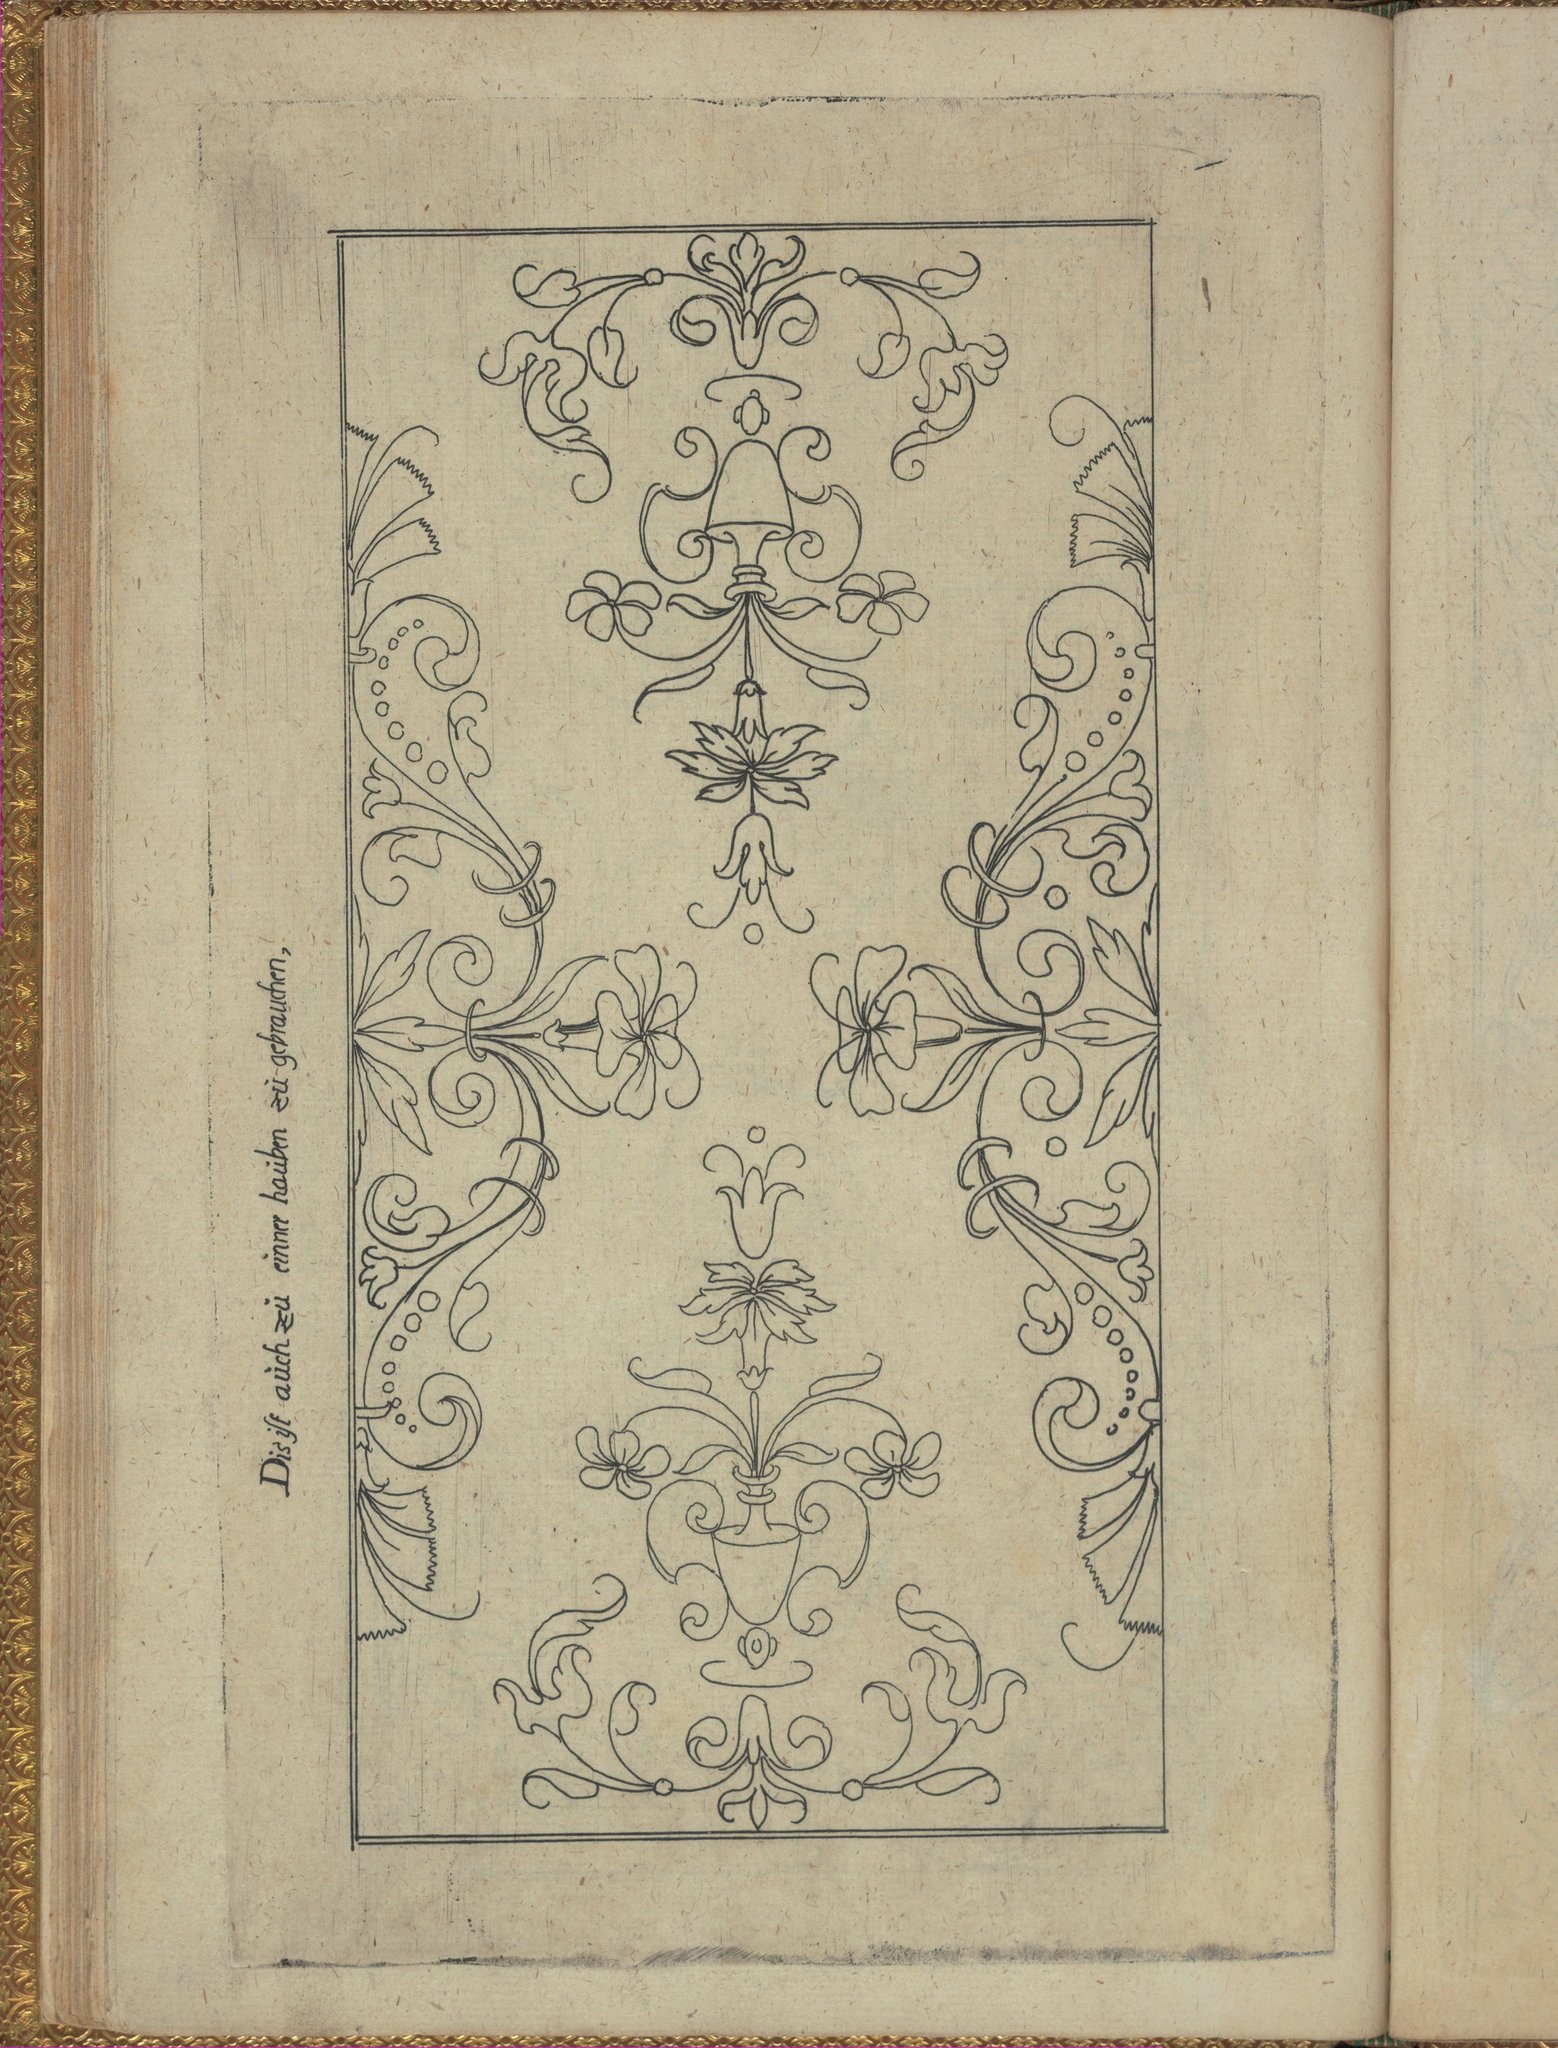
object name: book print ornament architecture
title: New Modelbüch (Page 48v)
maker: andreas bretschneider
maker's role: designer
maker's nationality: german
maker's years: 1573-1645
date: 1615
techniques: etching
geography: germany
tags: flowers